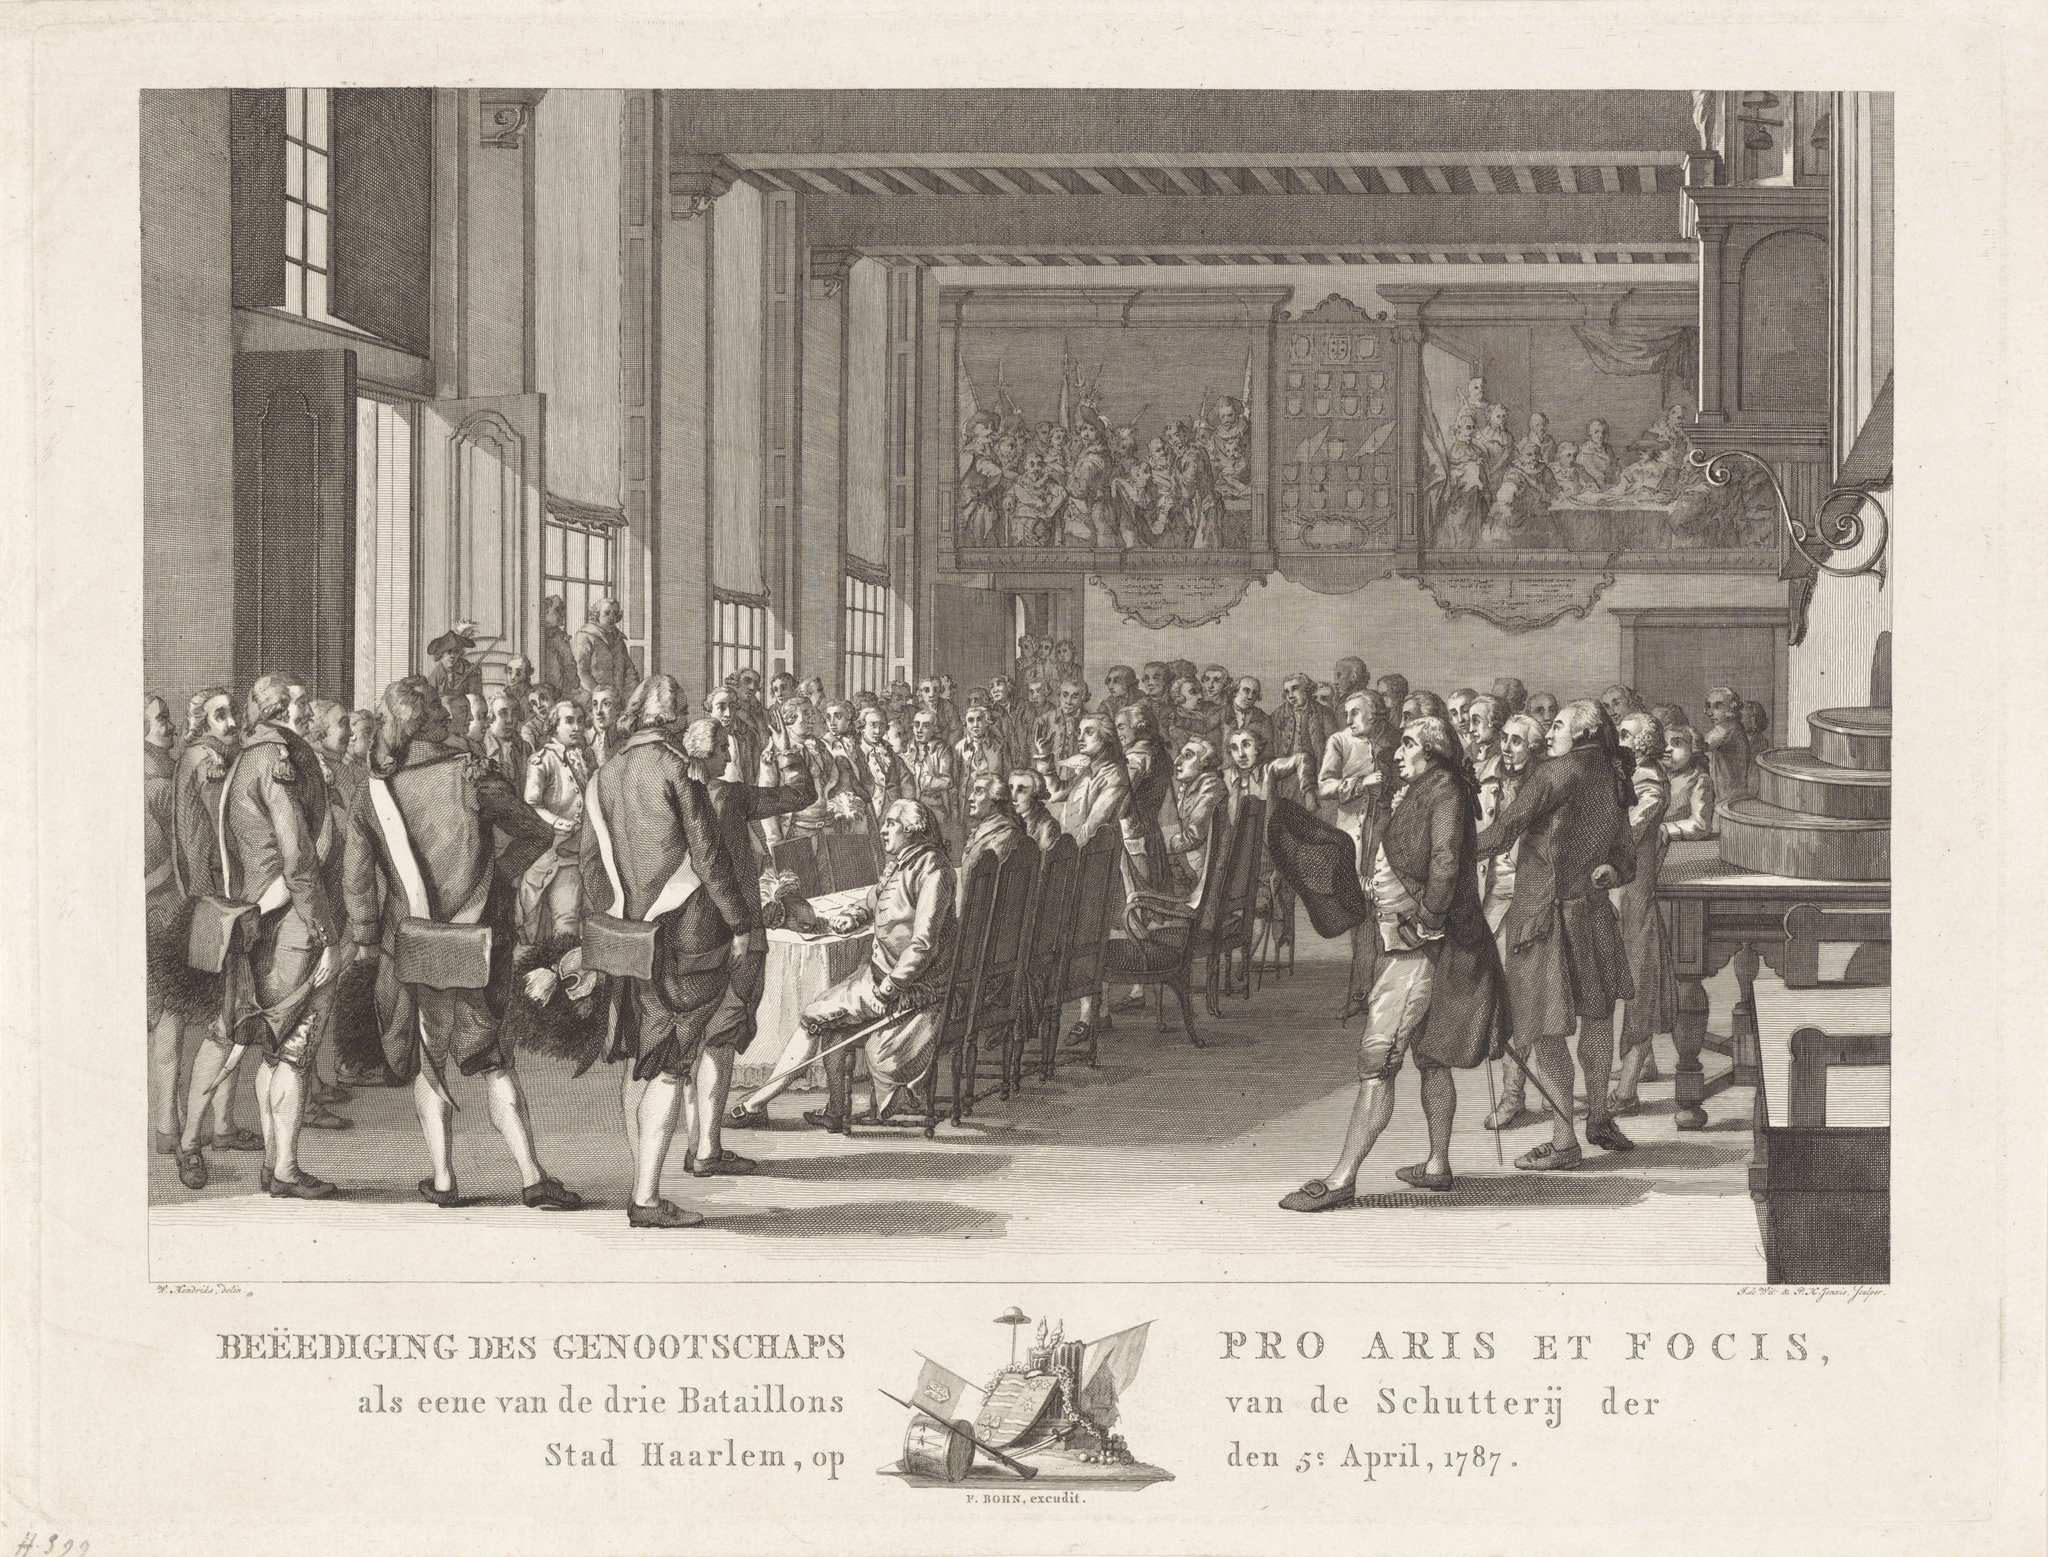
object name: print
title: Beëdiging van het genootschap Pro Aris et Focis te Haarlem, 1787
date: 1787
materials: paper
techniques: engraving, etching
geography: haarlem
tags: edifice, e.g.: public building, department store - aa - civic architecture: inside, swearing an oath (with two fingers raised), taking the oath ~ military service, patriots (1780-1795)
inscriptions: collector's mark: Lugt Lugt 2228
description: Interieur (grote zaal) van de Oude Doelen of Schuttersdoelen te Haarlem met de beëdiging van het Genootschap Pro Aris et Focis als een van de drie bataljons van de Haarlemse schutterij, 5 april 1787. Aan de muur hangen twee schutterstukken.